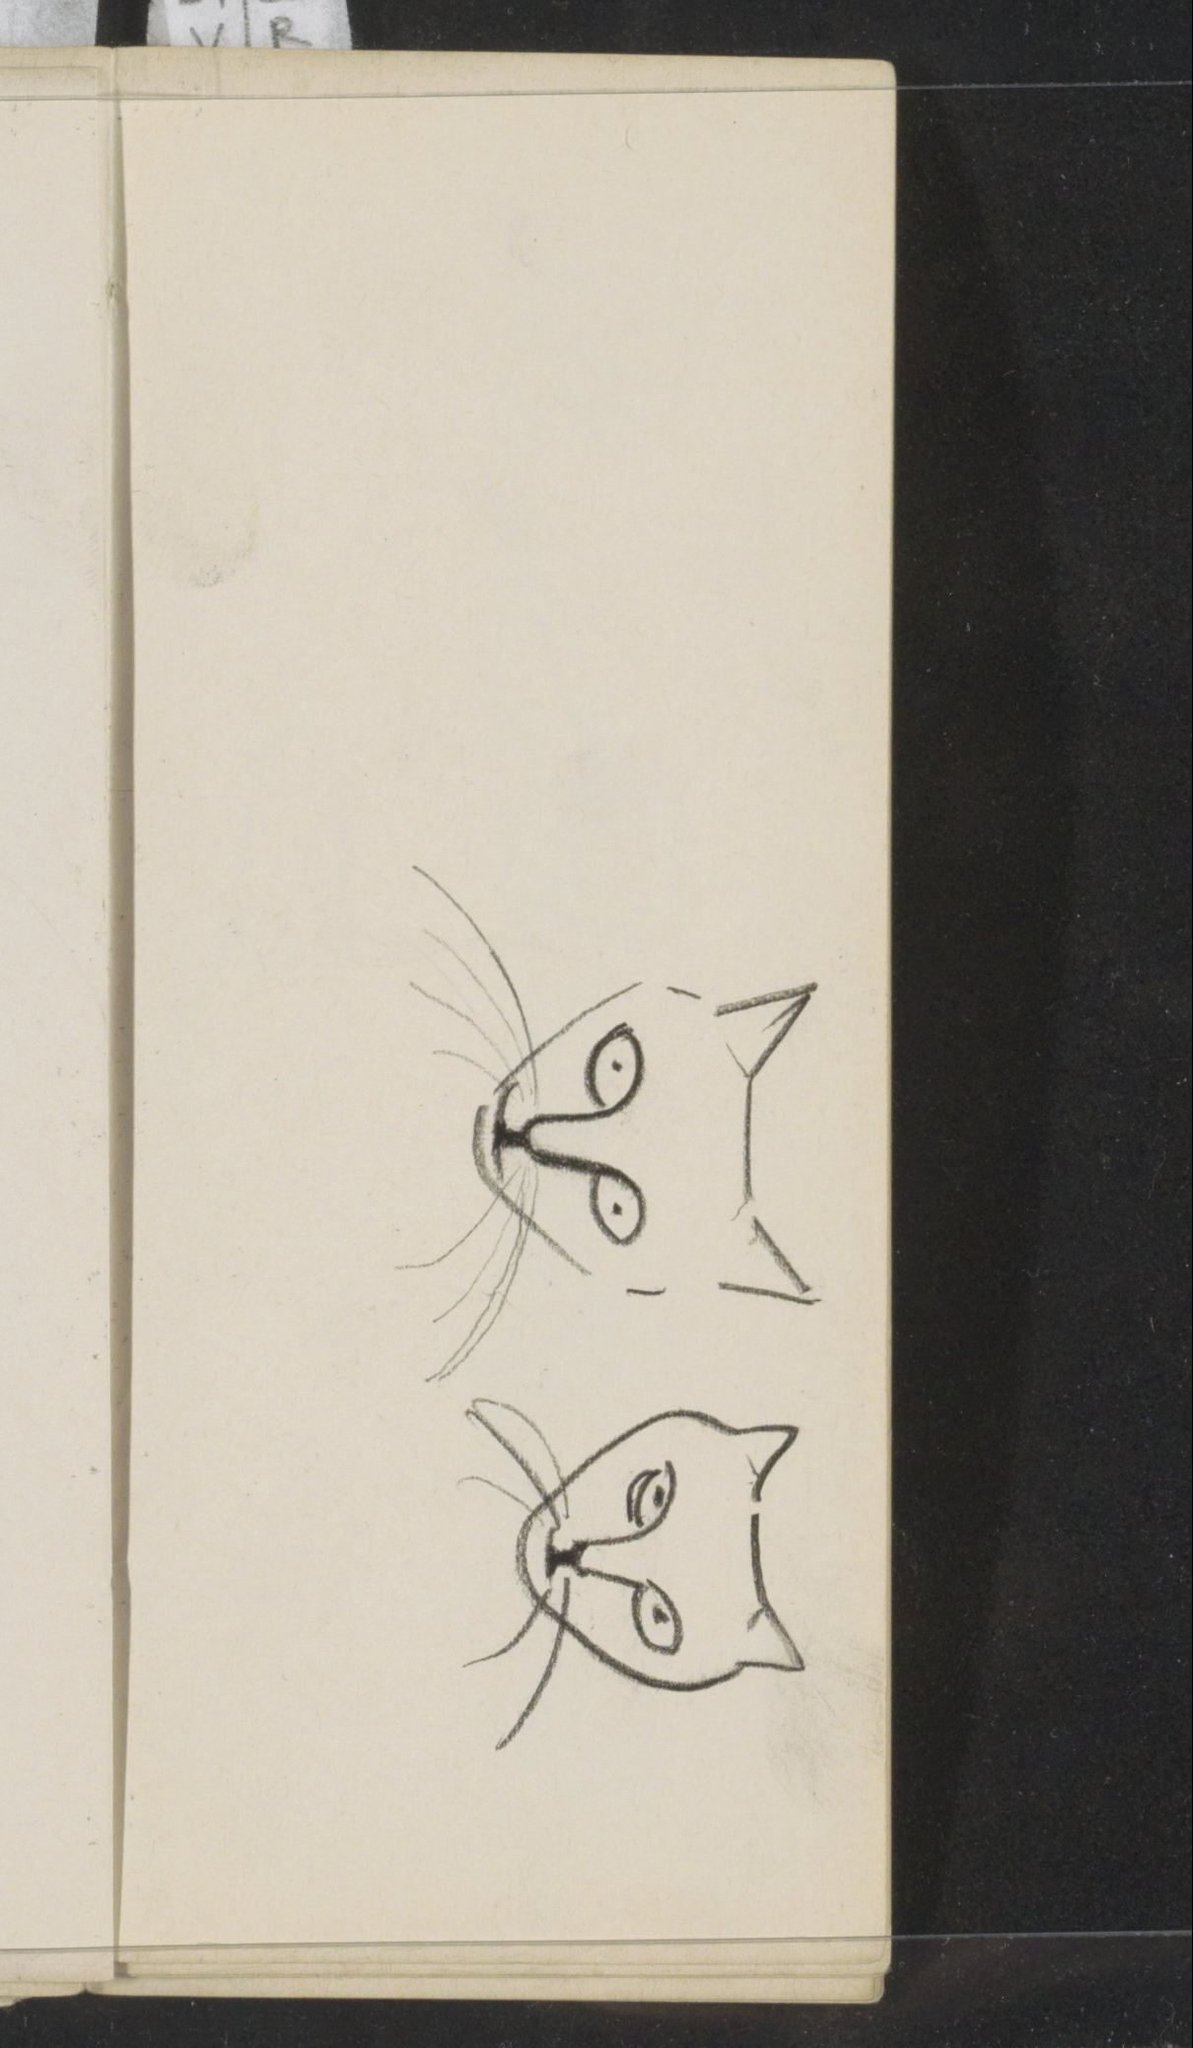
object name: sketchbook leaf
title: Koppen van twee katten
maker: gerrit willem dijsselhof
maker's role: designer, draughtsman, print maker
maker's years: 1866-1924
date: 1901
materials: chalk, paper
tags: cat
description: Blad 23 recto uit een schetsboek met 42 bladzijden.